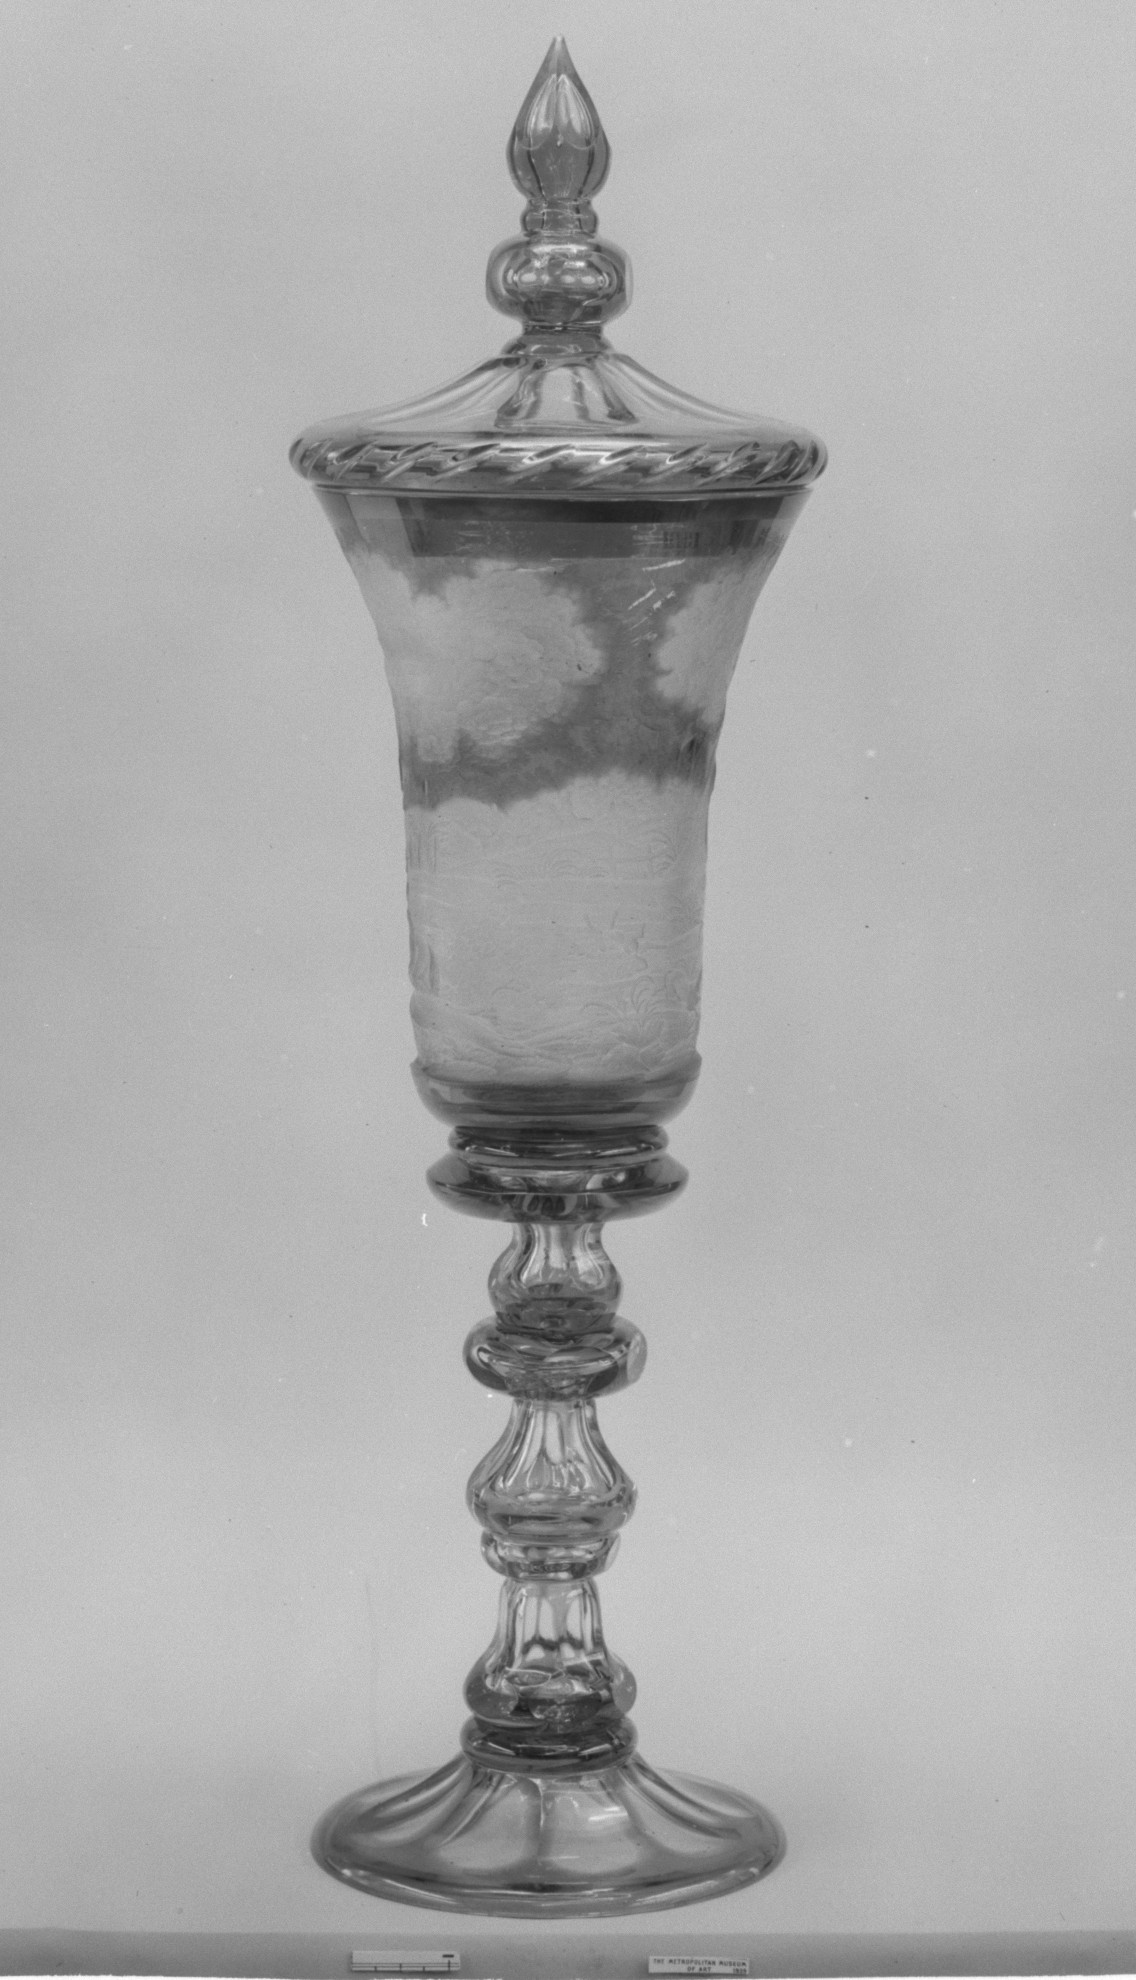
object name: goblet with cover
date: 1834-1866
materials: glass